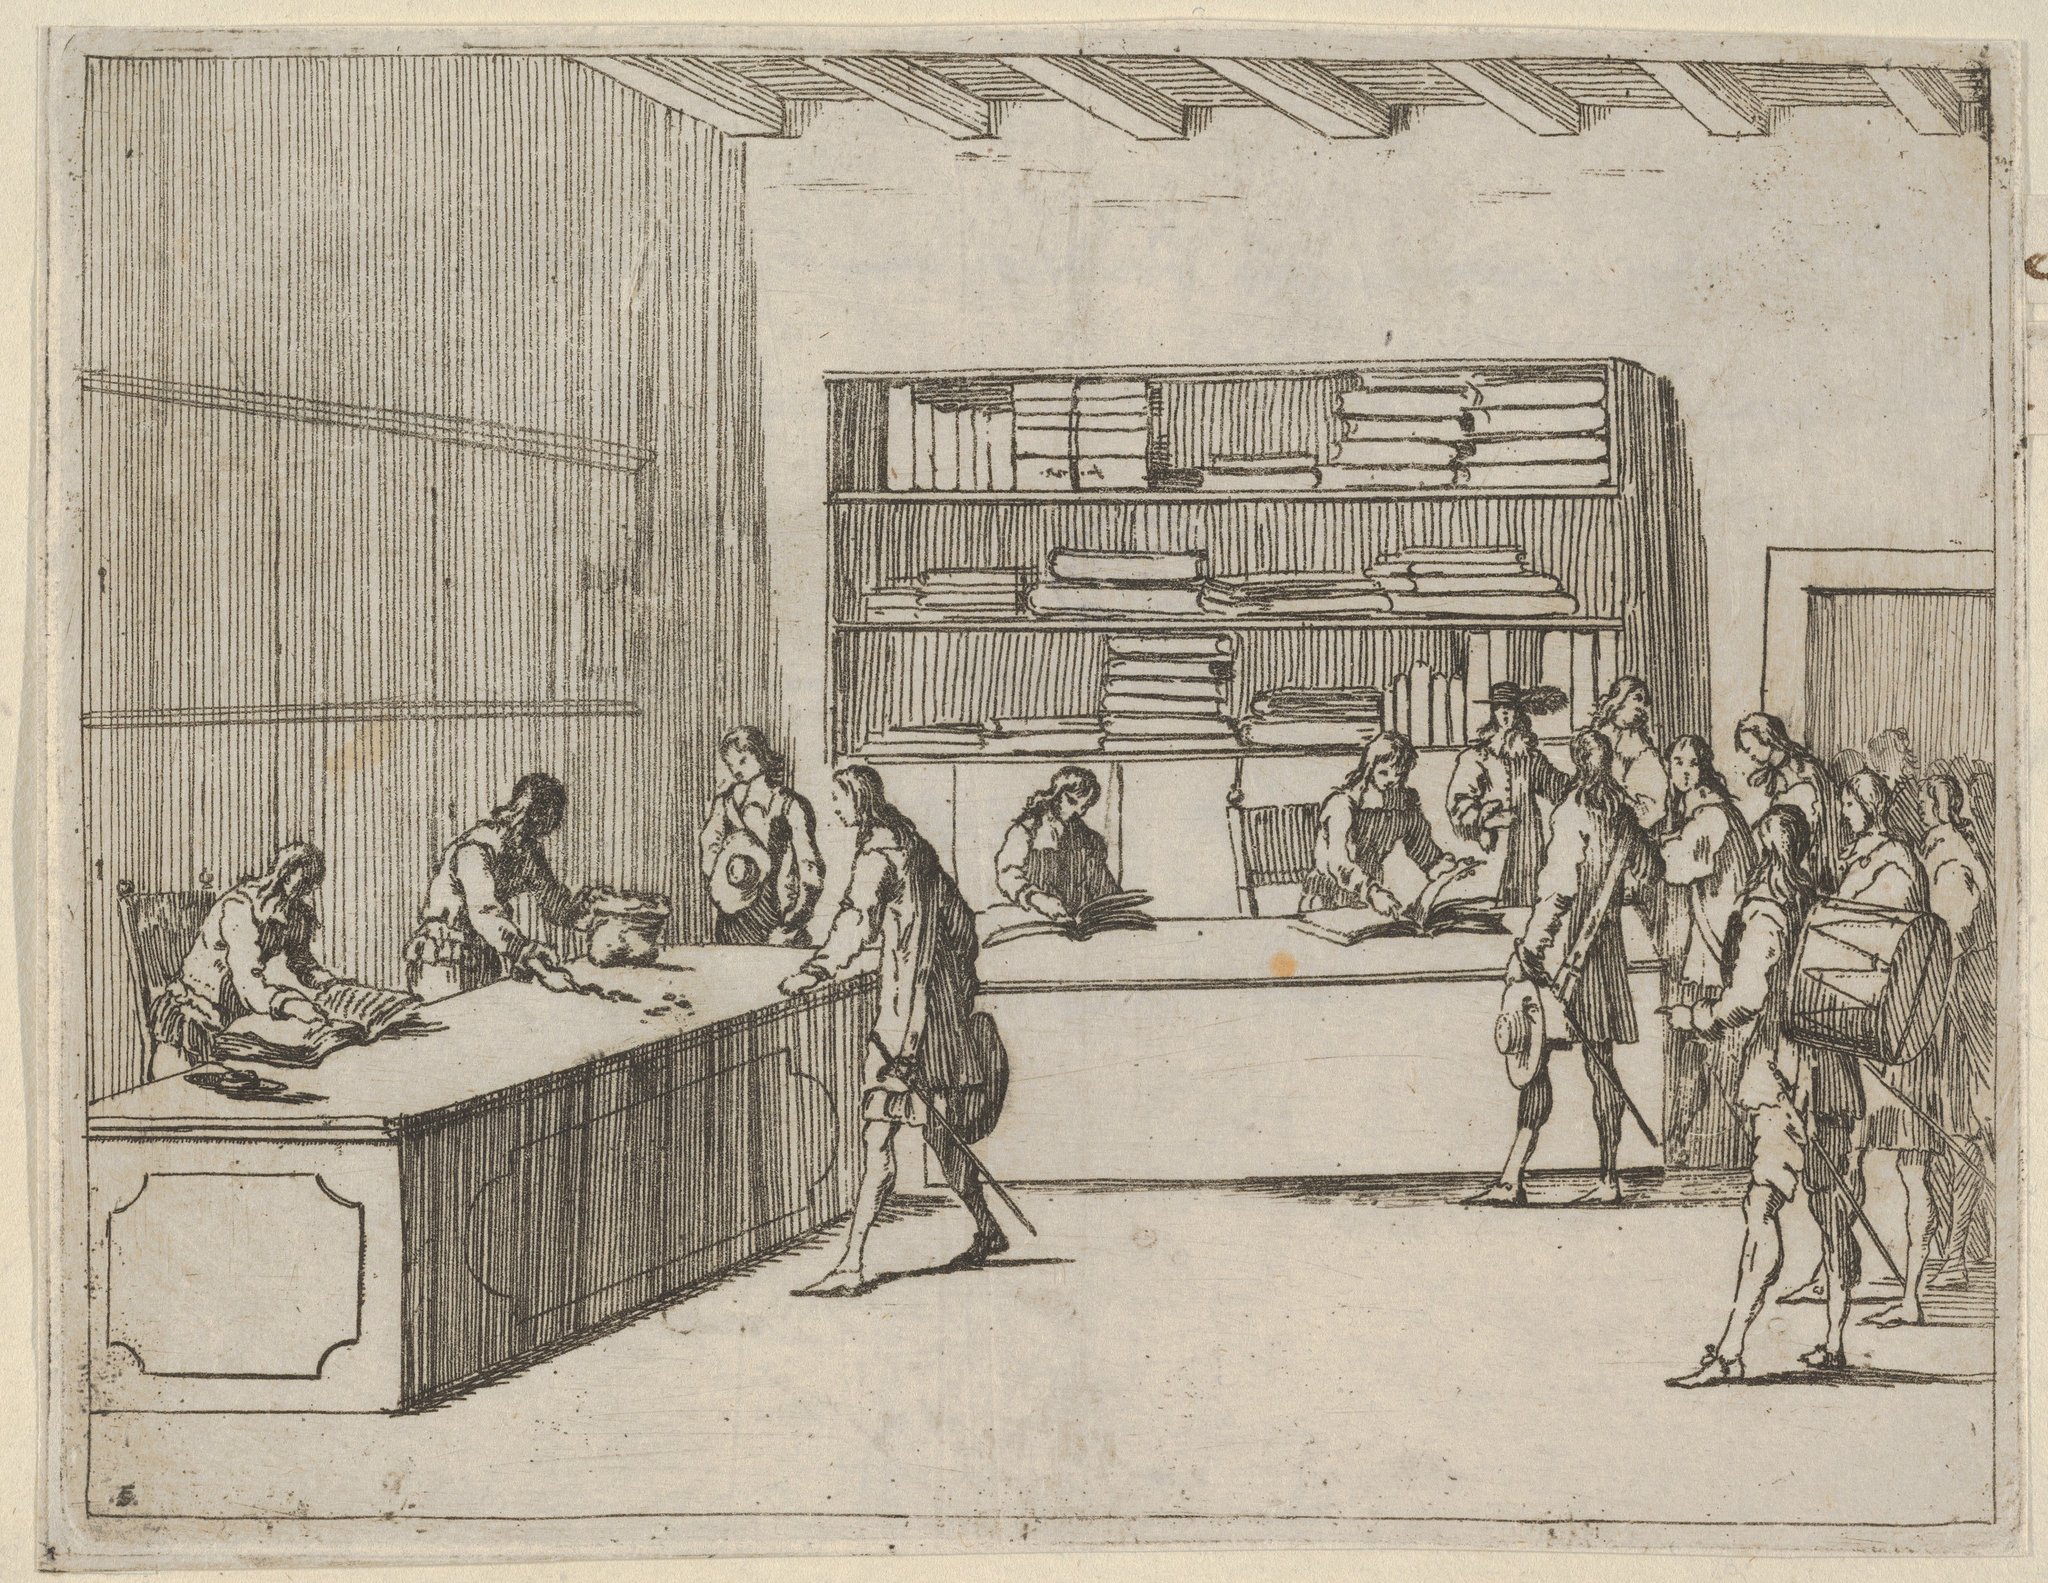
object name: print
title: Soldiers Enlisting to Defend the Faith agains the Turks, from "L'Idea di un Principe ed Eroe Cristiano in Francesco I d'Este, di Modena e Reggio Duca VIII [...]"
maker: bartolomeo fenice (fénis)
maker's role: artist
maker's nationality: italian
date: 1659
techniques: etching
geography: italy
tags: books,soldiers,men,women